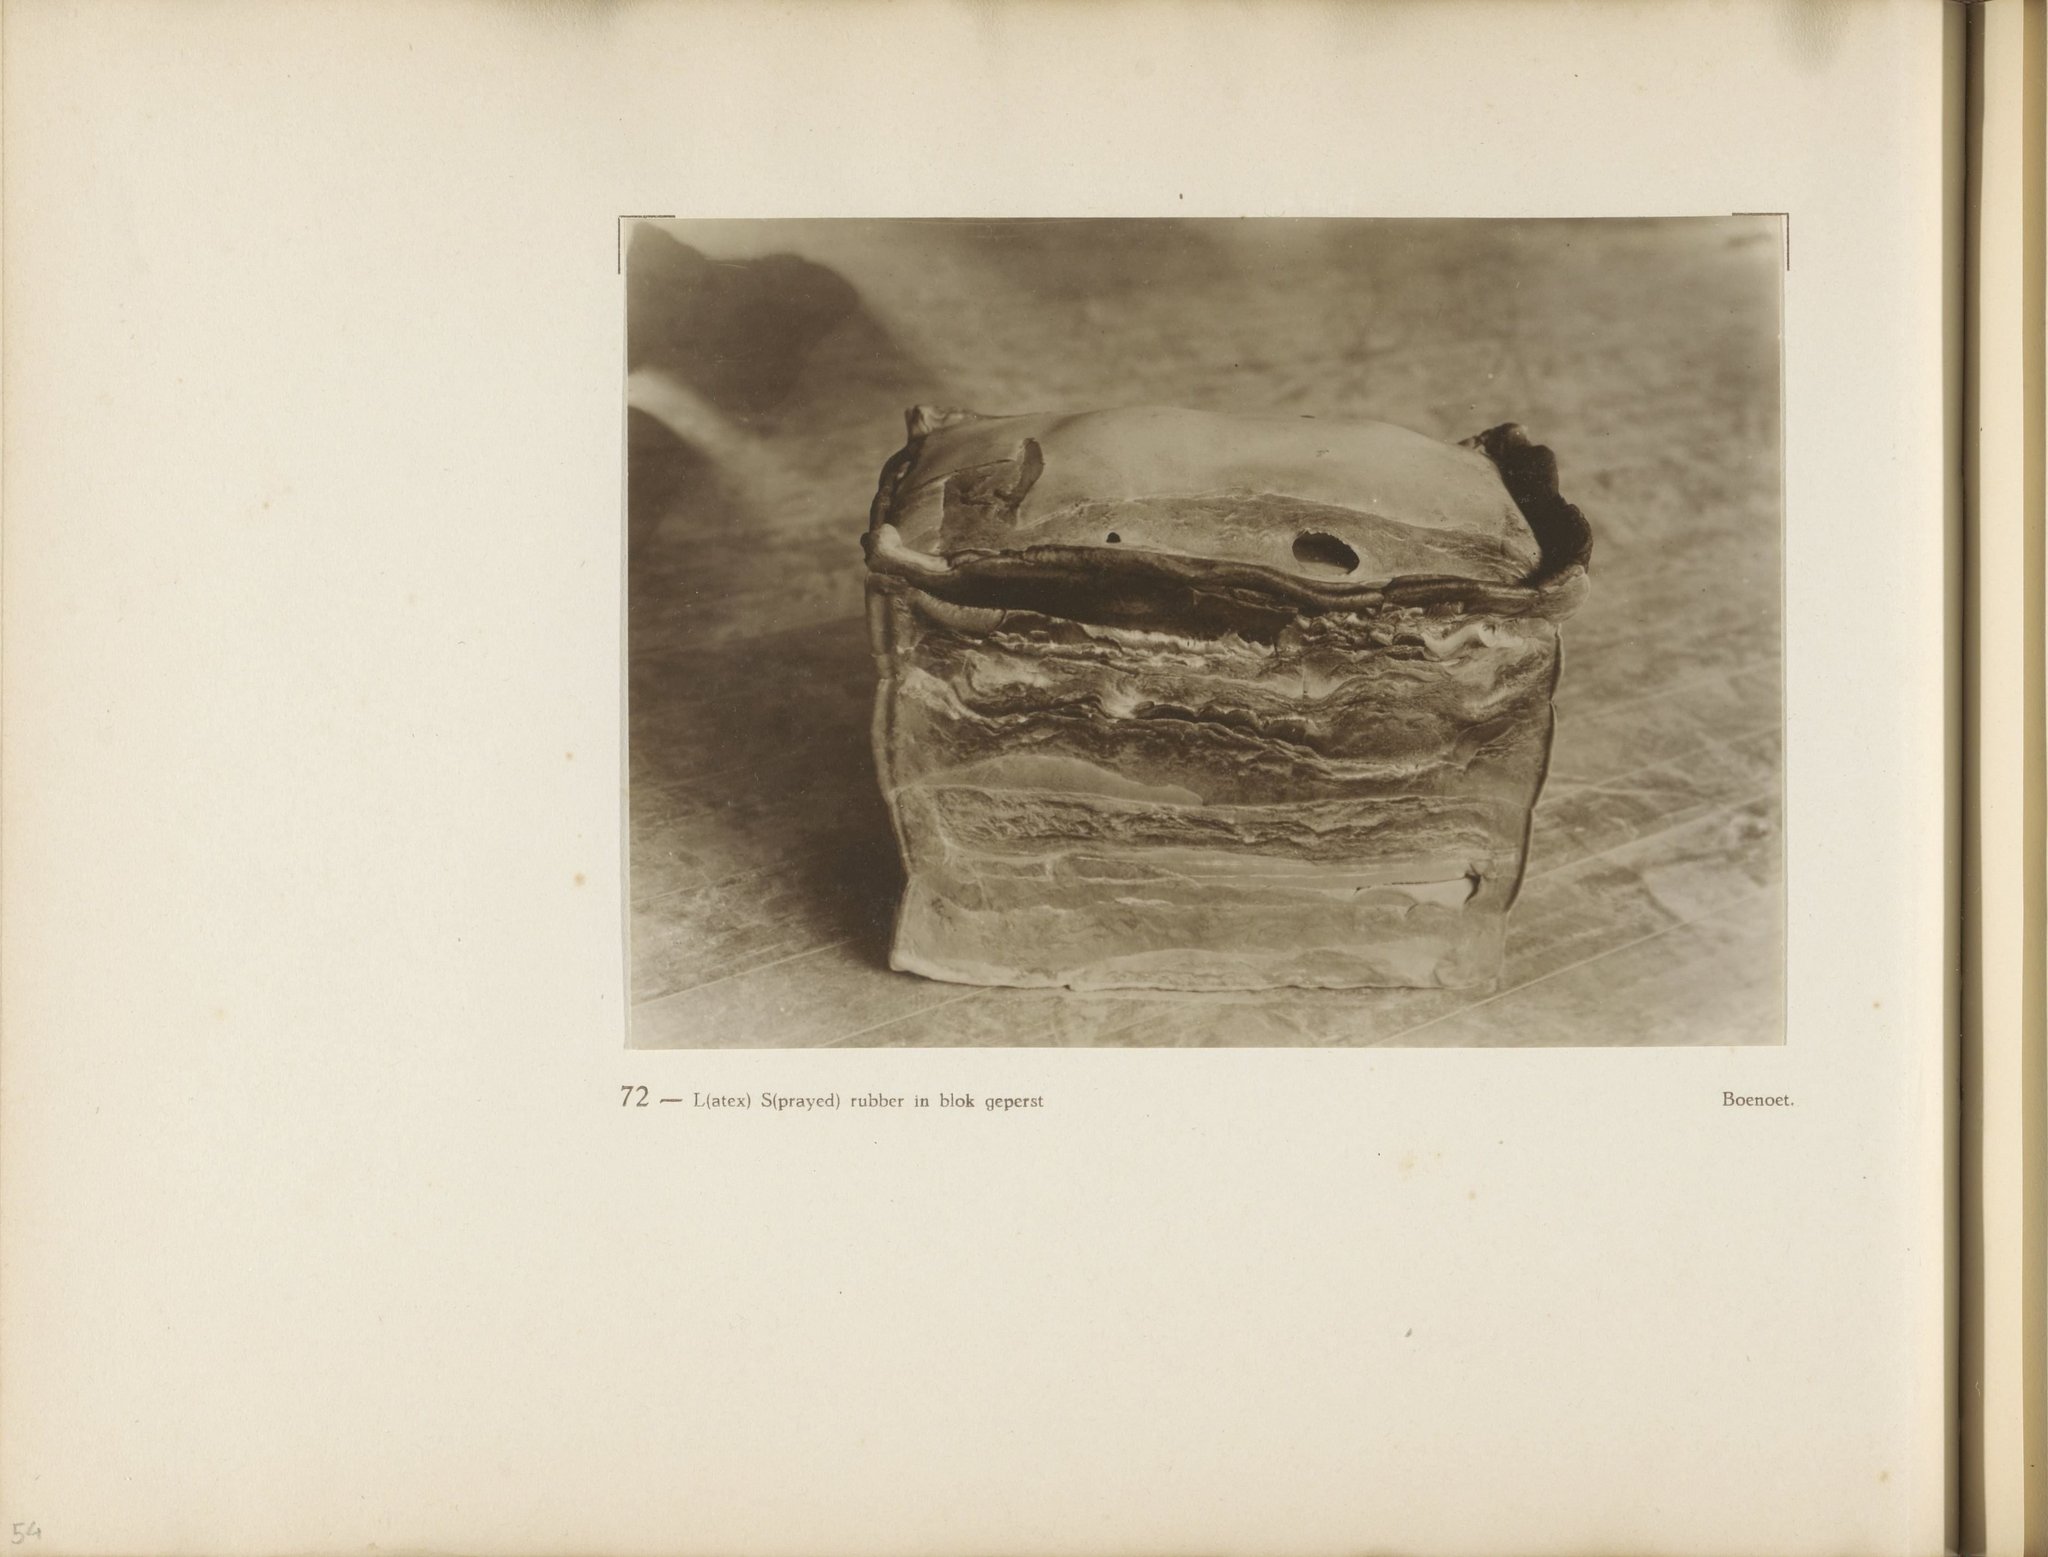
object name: album leaf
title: Pagina 72 van fotoboek van de Algemeene Vereeniging van Rubberplanters ter Oostkust van Sumatra (A.V.R.O.S.)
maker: j.w. meyster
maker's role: fotograaf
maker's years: 1887-1945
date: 1924-1925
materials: paper, photographic support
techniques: printing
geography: sumatra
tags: factory-interior, machine shop, (non-fruit) products of plants or trees: rubber, sumatra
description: Boekpagina met een foto van een blok Latex Sprayed (LS) rubber vervaardigd in een rubberfabriek van de Algemeene Vereeniging van Rubberplanters ter Oostkust van Sumatra (A.V.R.O.S.) te Boenoet. Onderdeel van een fotoboek van de Algemeene Vereeniging van Rubberplanters ter Oostkust van Sumatra (A.V.R.O.S.).